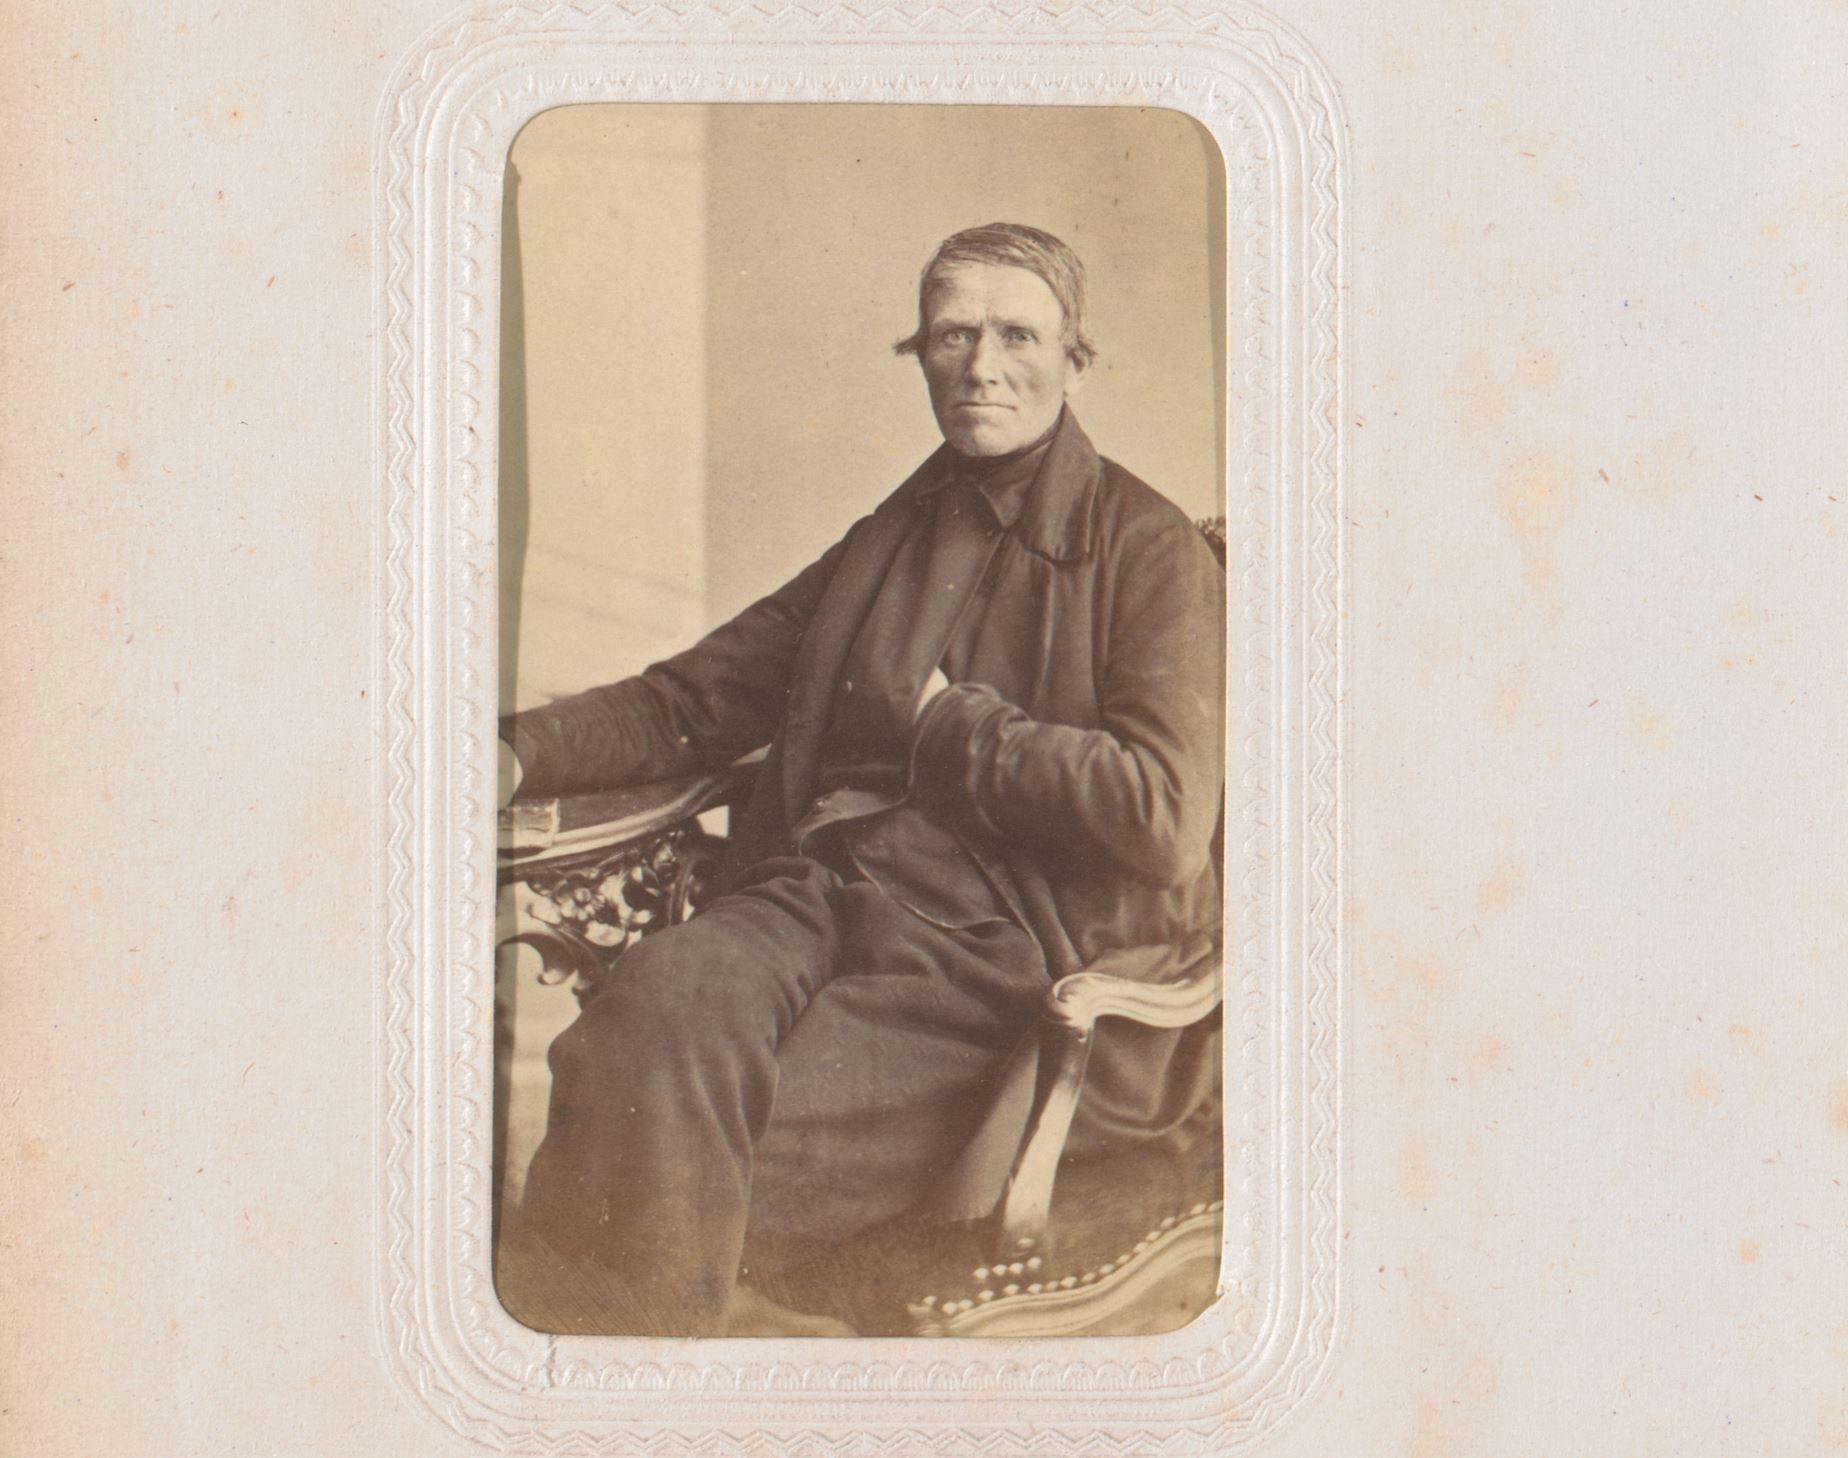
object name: photograph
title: Portret van een zittende man met een hand in zijn jas gestoken, aangeduid als Vermeulen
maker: kornelis willem schorteldoek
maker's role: boekbinder, fotograaf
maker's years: 1800-1885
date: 1855-1885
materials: cardboard, photographic support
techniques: albumen print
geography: gorinchem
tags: sitting figure, coat, historical persons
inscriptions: inscription: ‘SCHORTELDOEK/ PHOTOGRAAF/ GORINCHEM/ Groote Markt’, name: ‘Vermeulen’